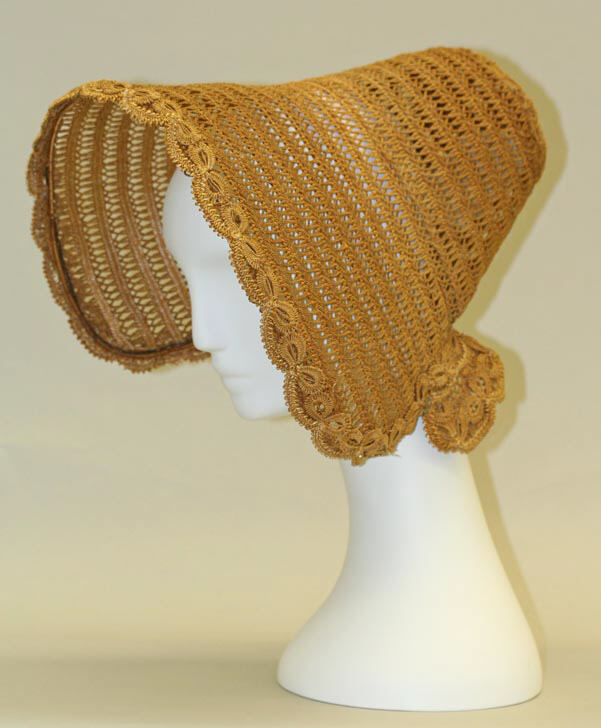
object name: bonnet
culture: american or european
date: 1830-1839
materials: fiber